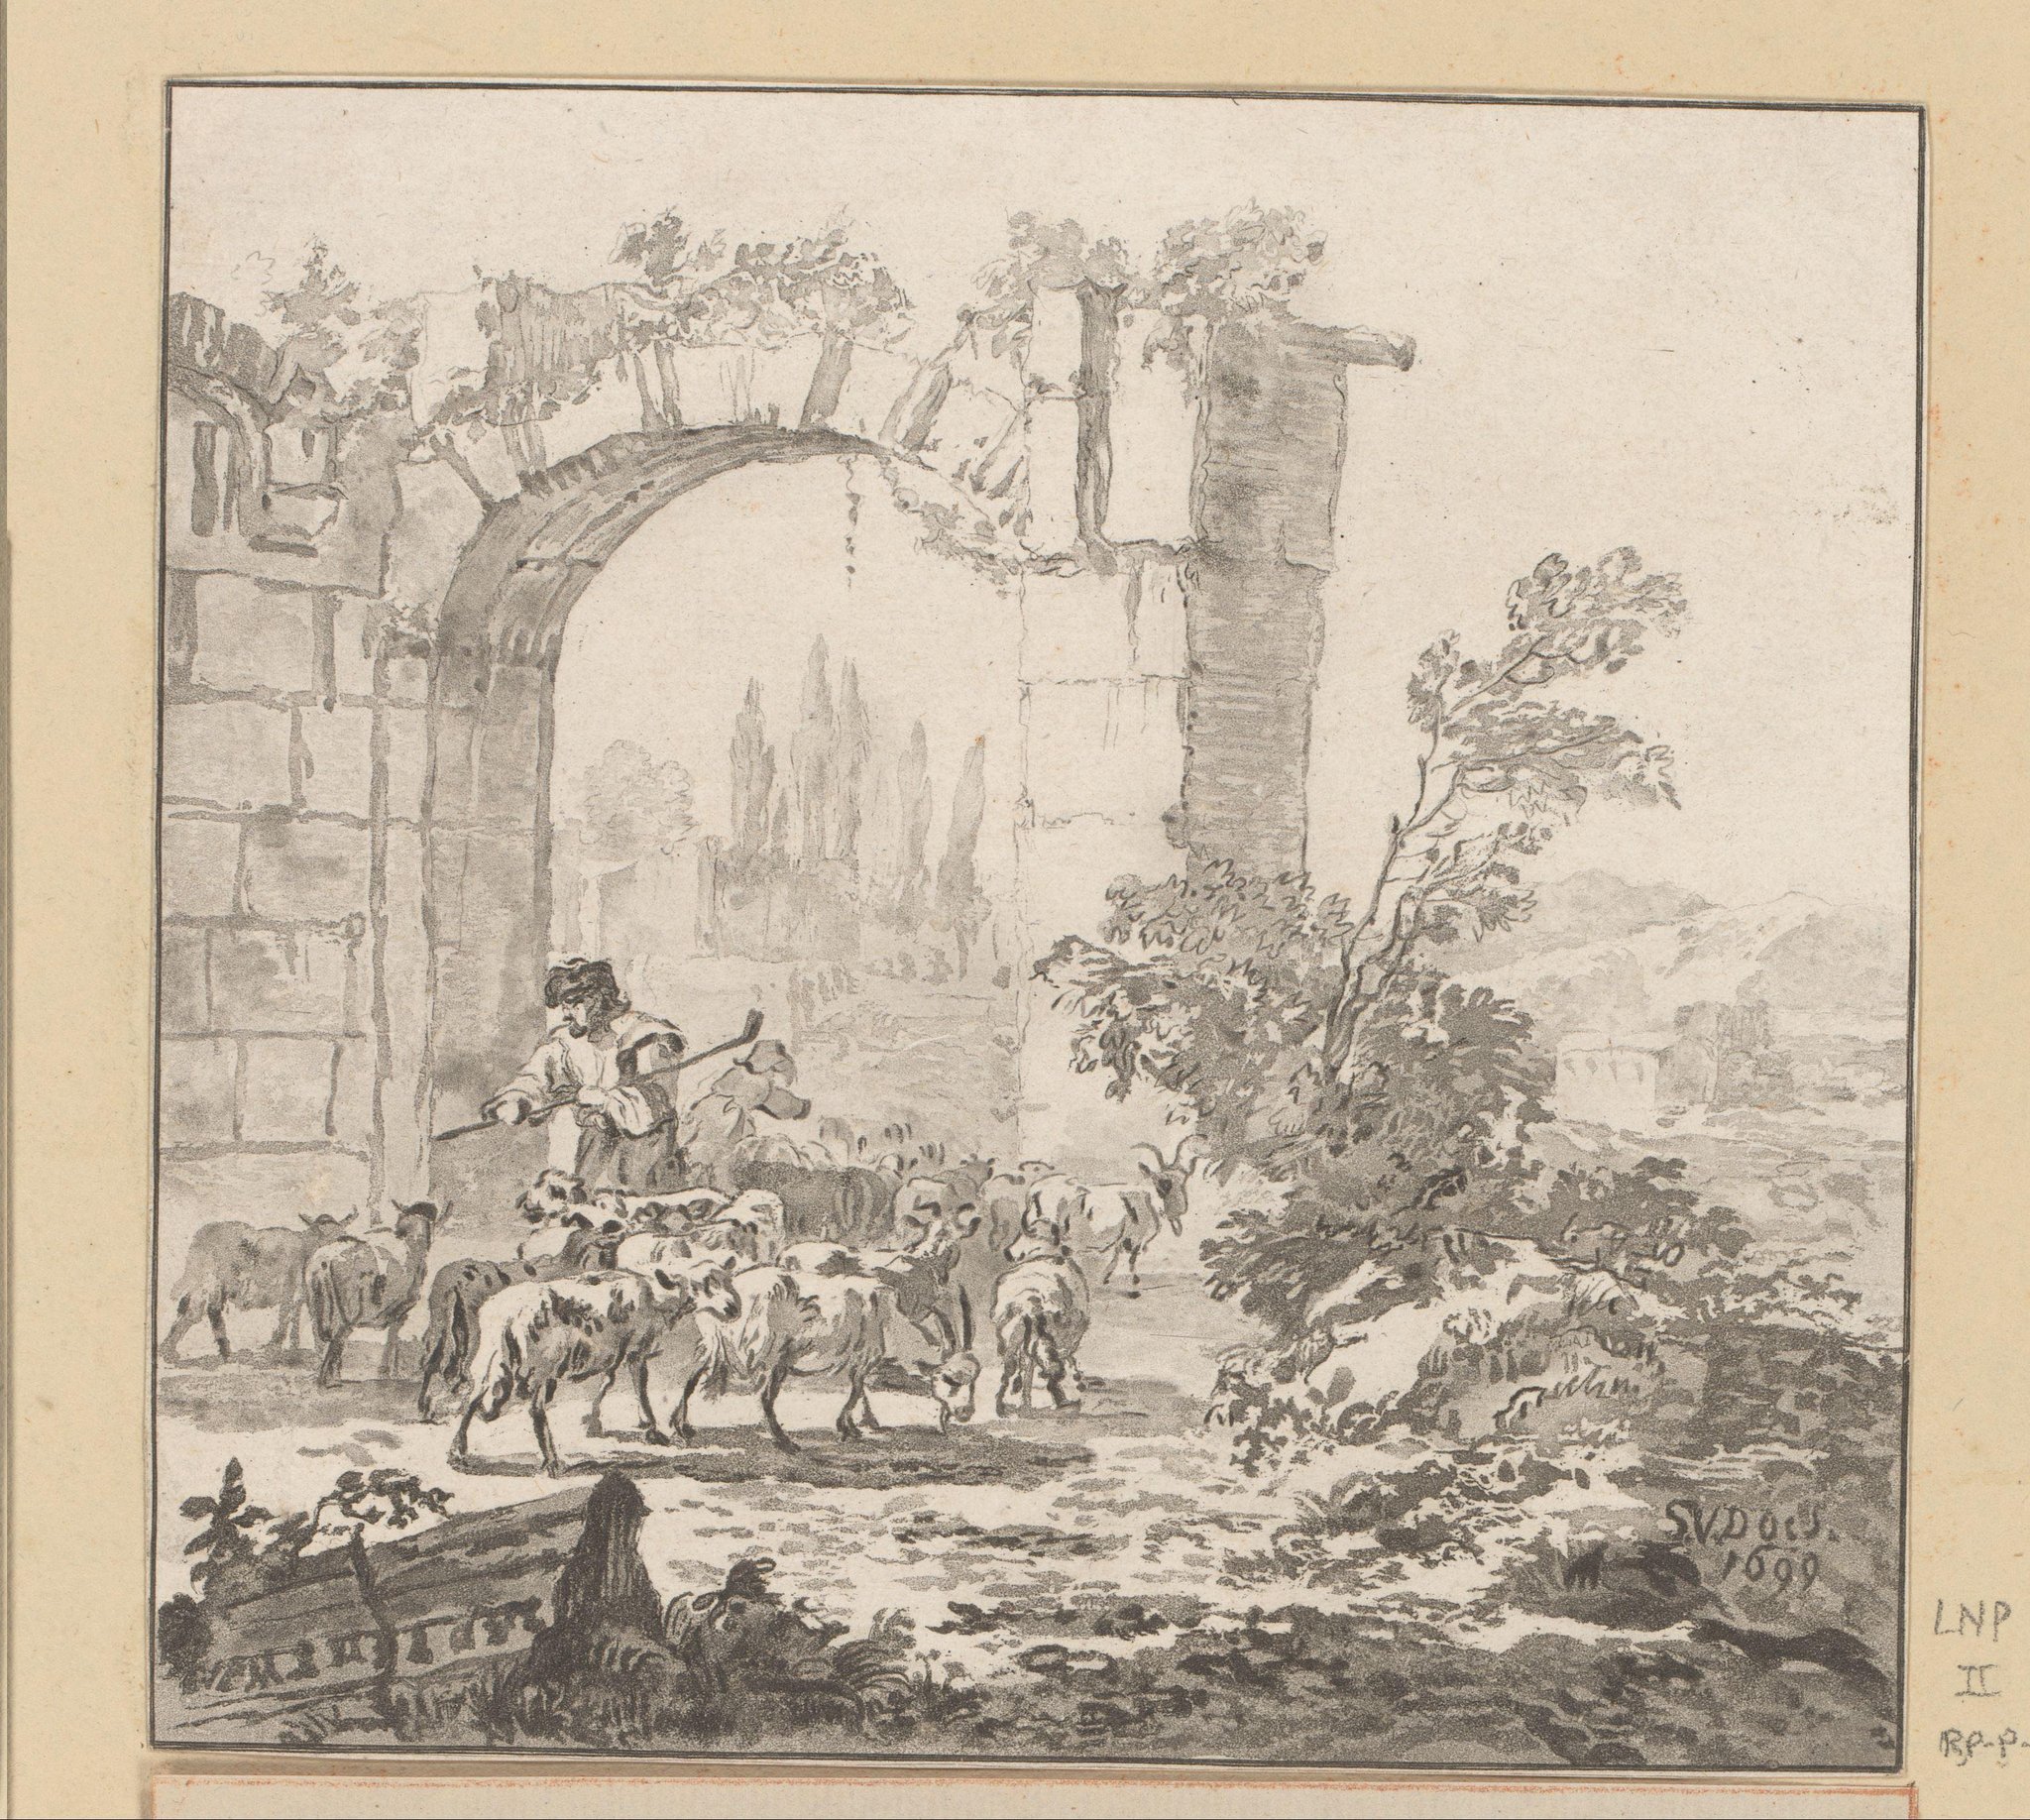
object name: print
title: Kudde geiten bij een poort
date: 1781-1786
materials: paper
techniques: transfer, print drawing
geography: amsterdam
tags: herding, herdsman, herdswoman, shepherd, shepherdess, cowherd, etc., landscape with ruins, goat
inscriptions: collector's mark: ‘RIJKS / MUSM’, collector's mark: Lugt 2725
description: Een herder met een kudde geiten bij een poort. Op de achtergrond cipressen. De prent ligt los in een album, zie blad 39.